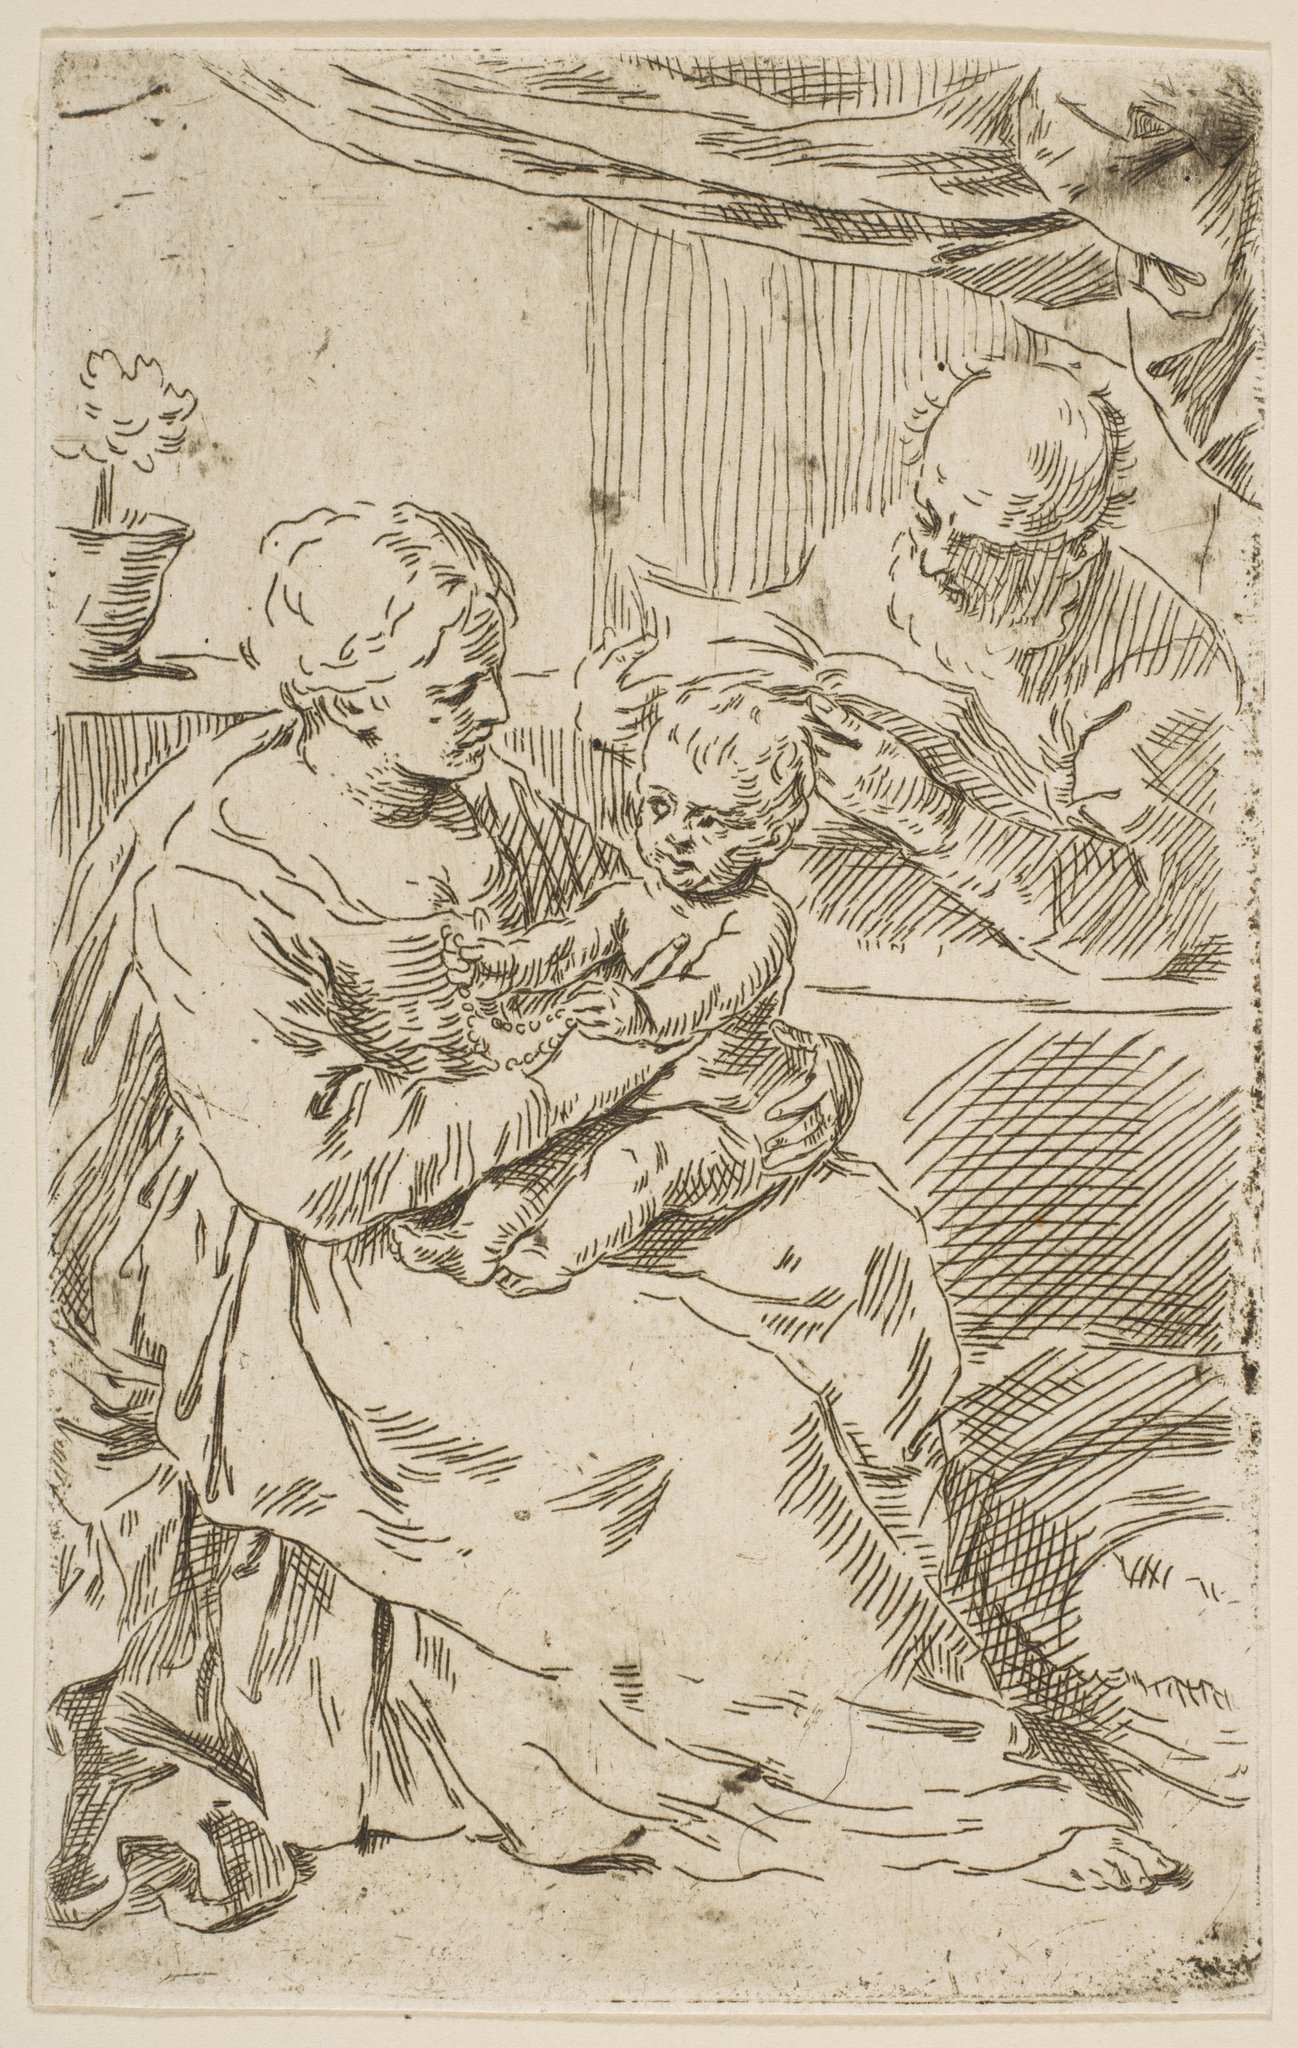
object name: print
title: Holy Family with a Rosary, copy after Cantarini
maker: simone cantarini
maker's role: artist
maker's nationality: italian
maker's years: 1612-1648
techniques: etching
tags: holy family,rosaries